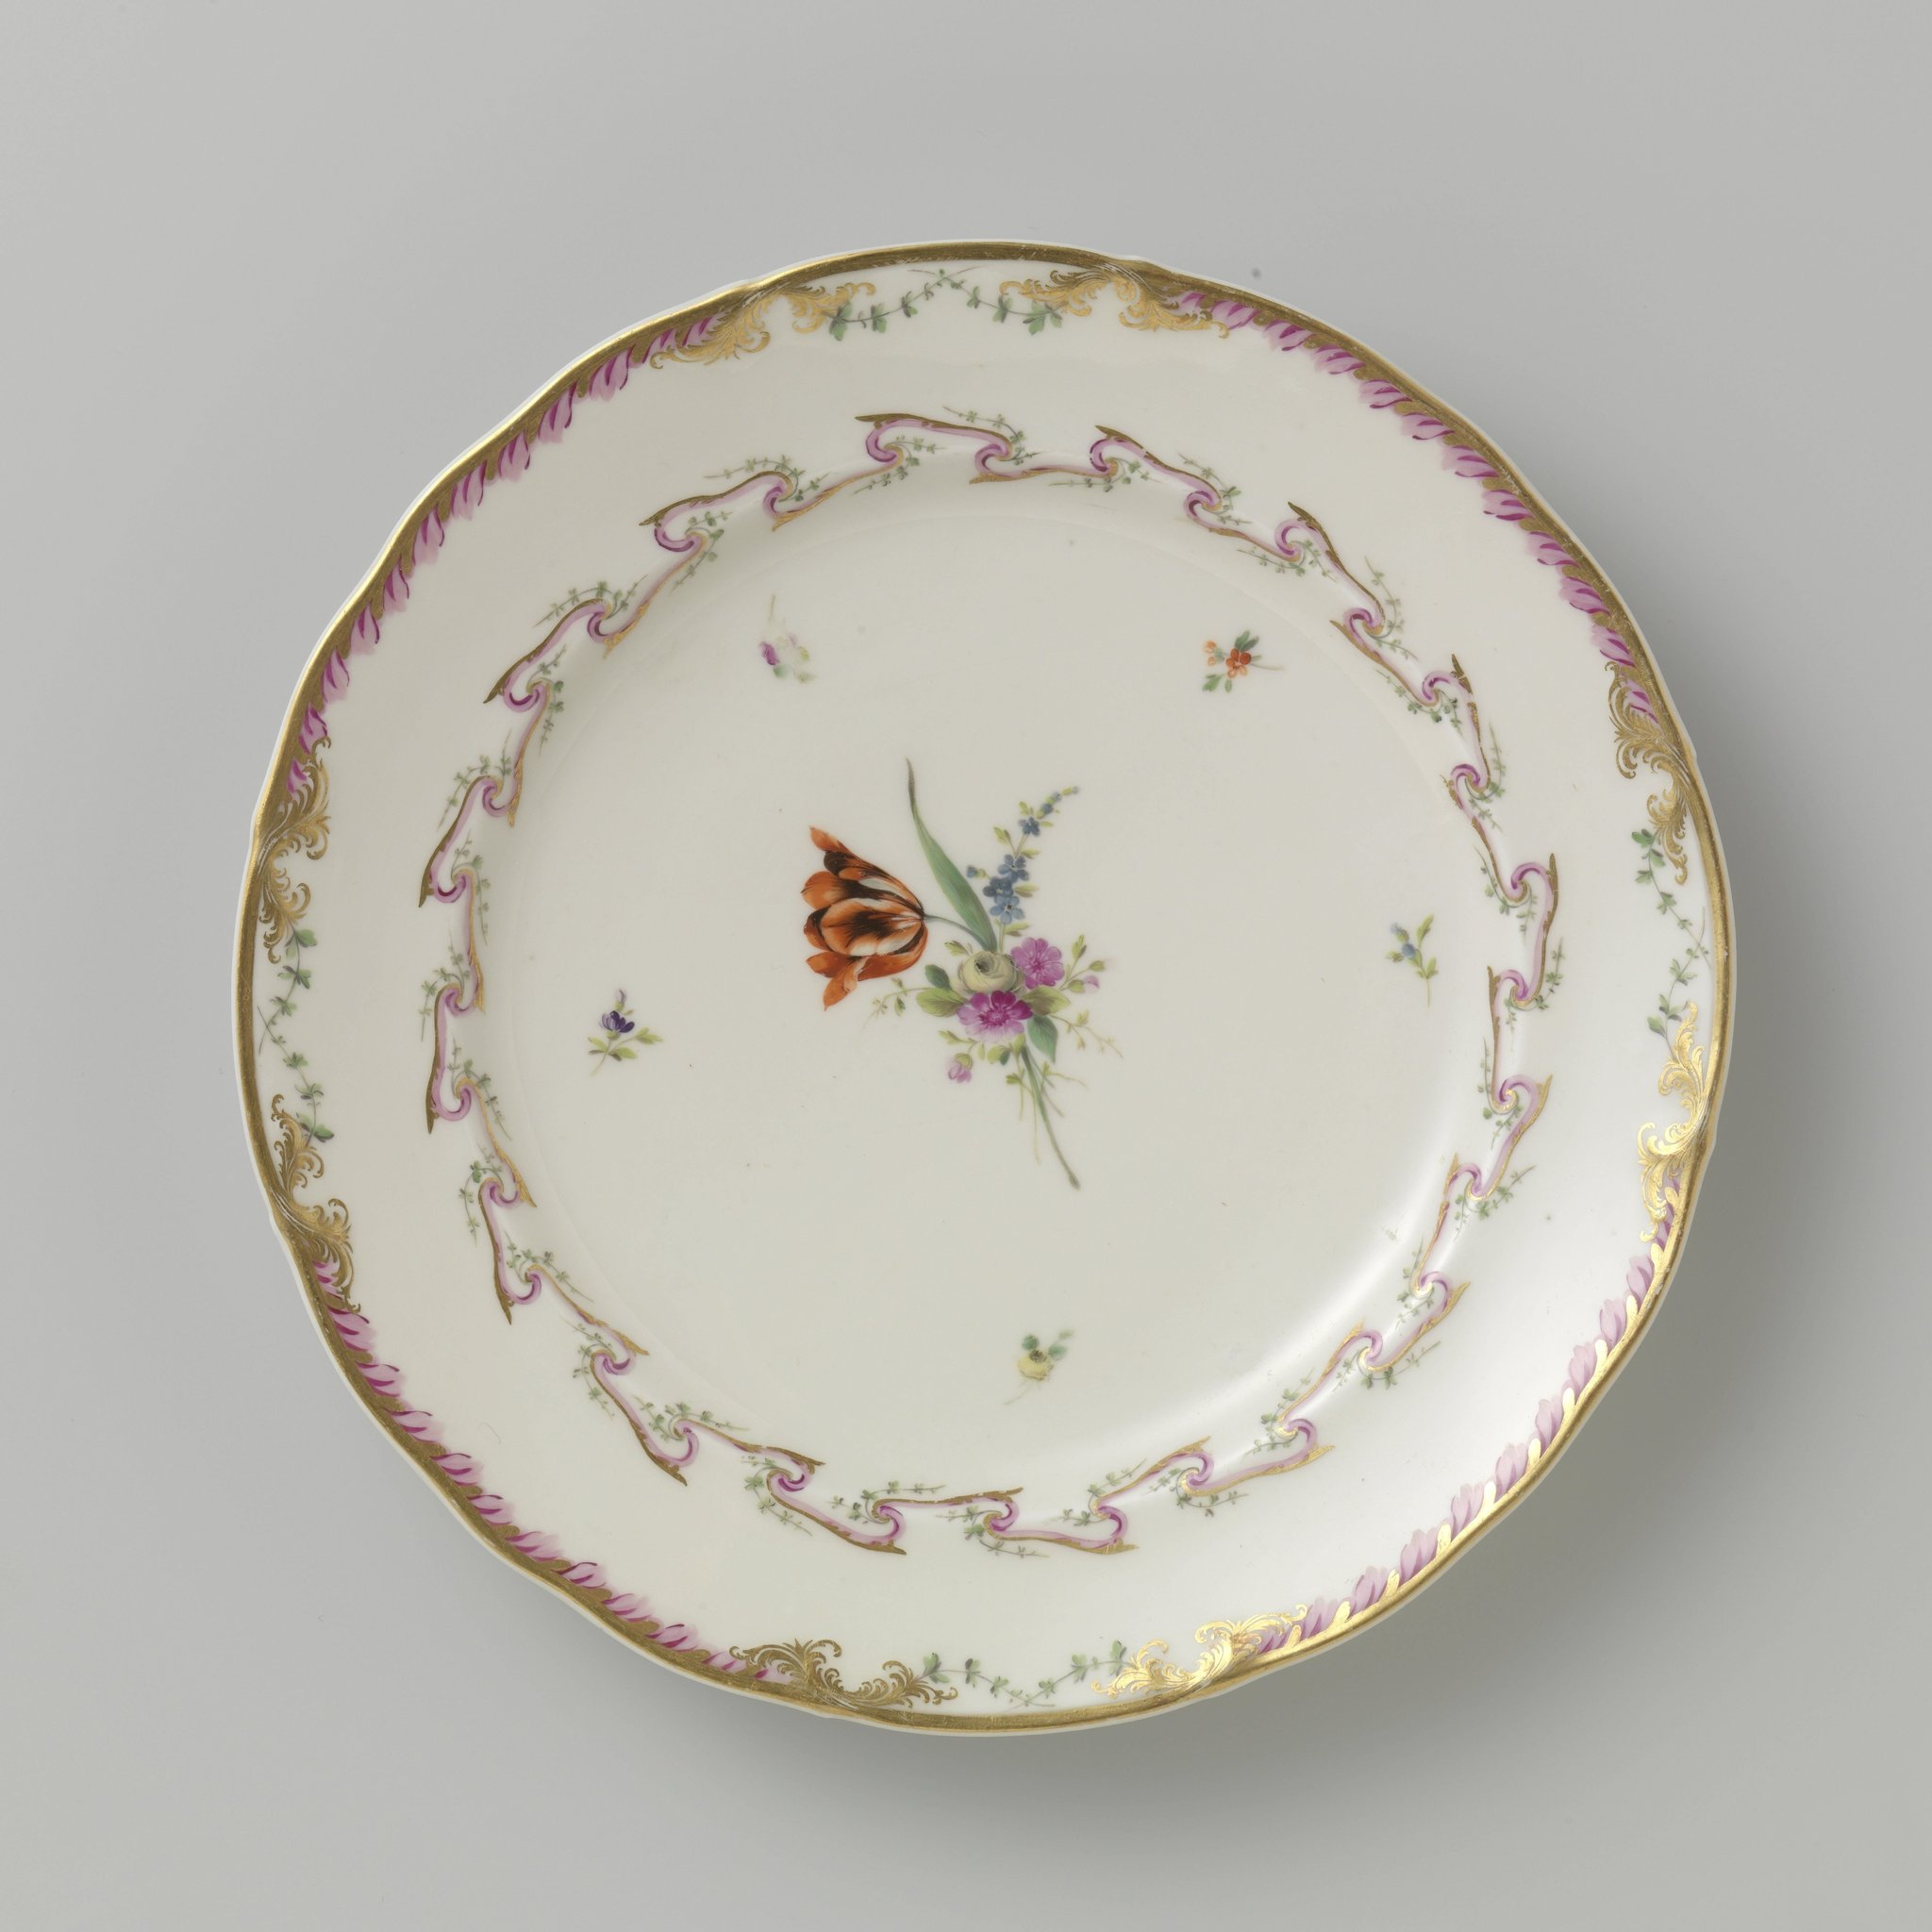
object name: plate dish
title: Bord, plat model, behorend bij een servies met geslingerd lintmotief met bladertakken, bloemboeketten en gestrooide bloemtakken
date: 1780-1820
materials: porcelain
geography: paris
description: Bord, plat model, behorend bij een servies van porselein met geslingerd lintmotief in paars en goud met groene bladertakken, bloemboeketten en gestrooide bloemtakken. Randen lichtgegolfd met decoratie in goud met paars bladmotief waartussen groen gekruist bladmotief. Gemerkt: Mf. DE DIHL ET GUERHARD à PARIS. Serie van elf stuks. Opmerking: modern.